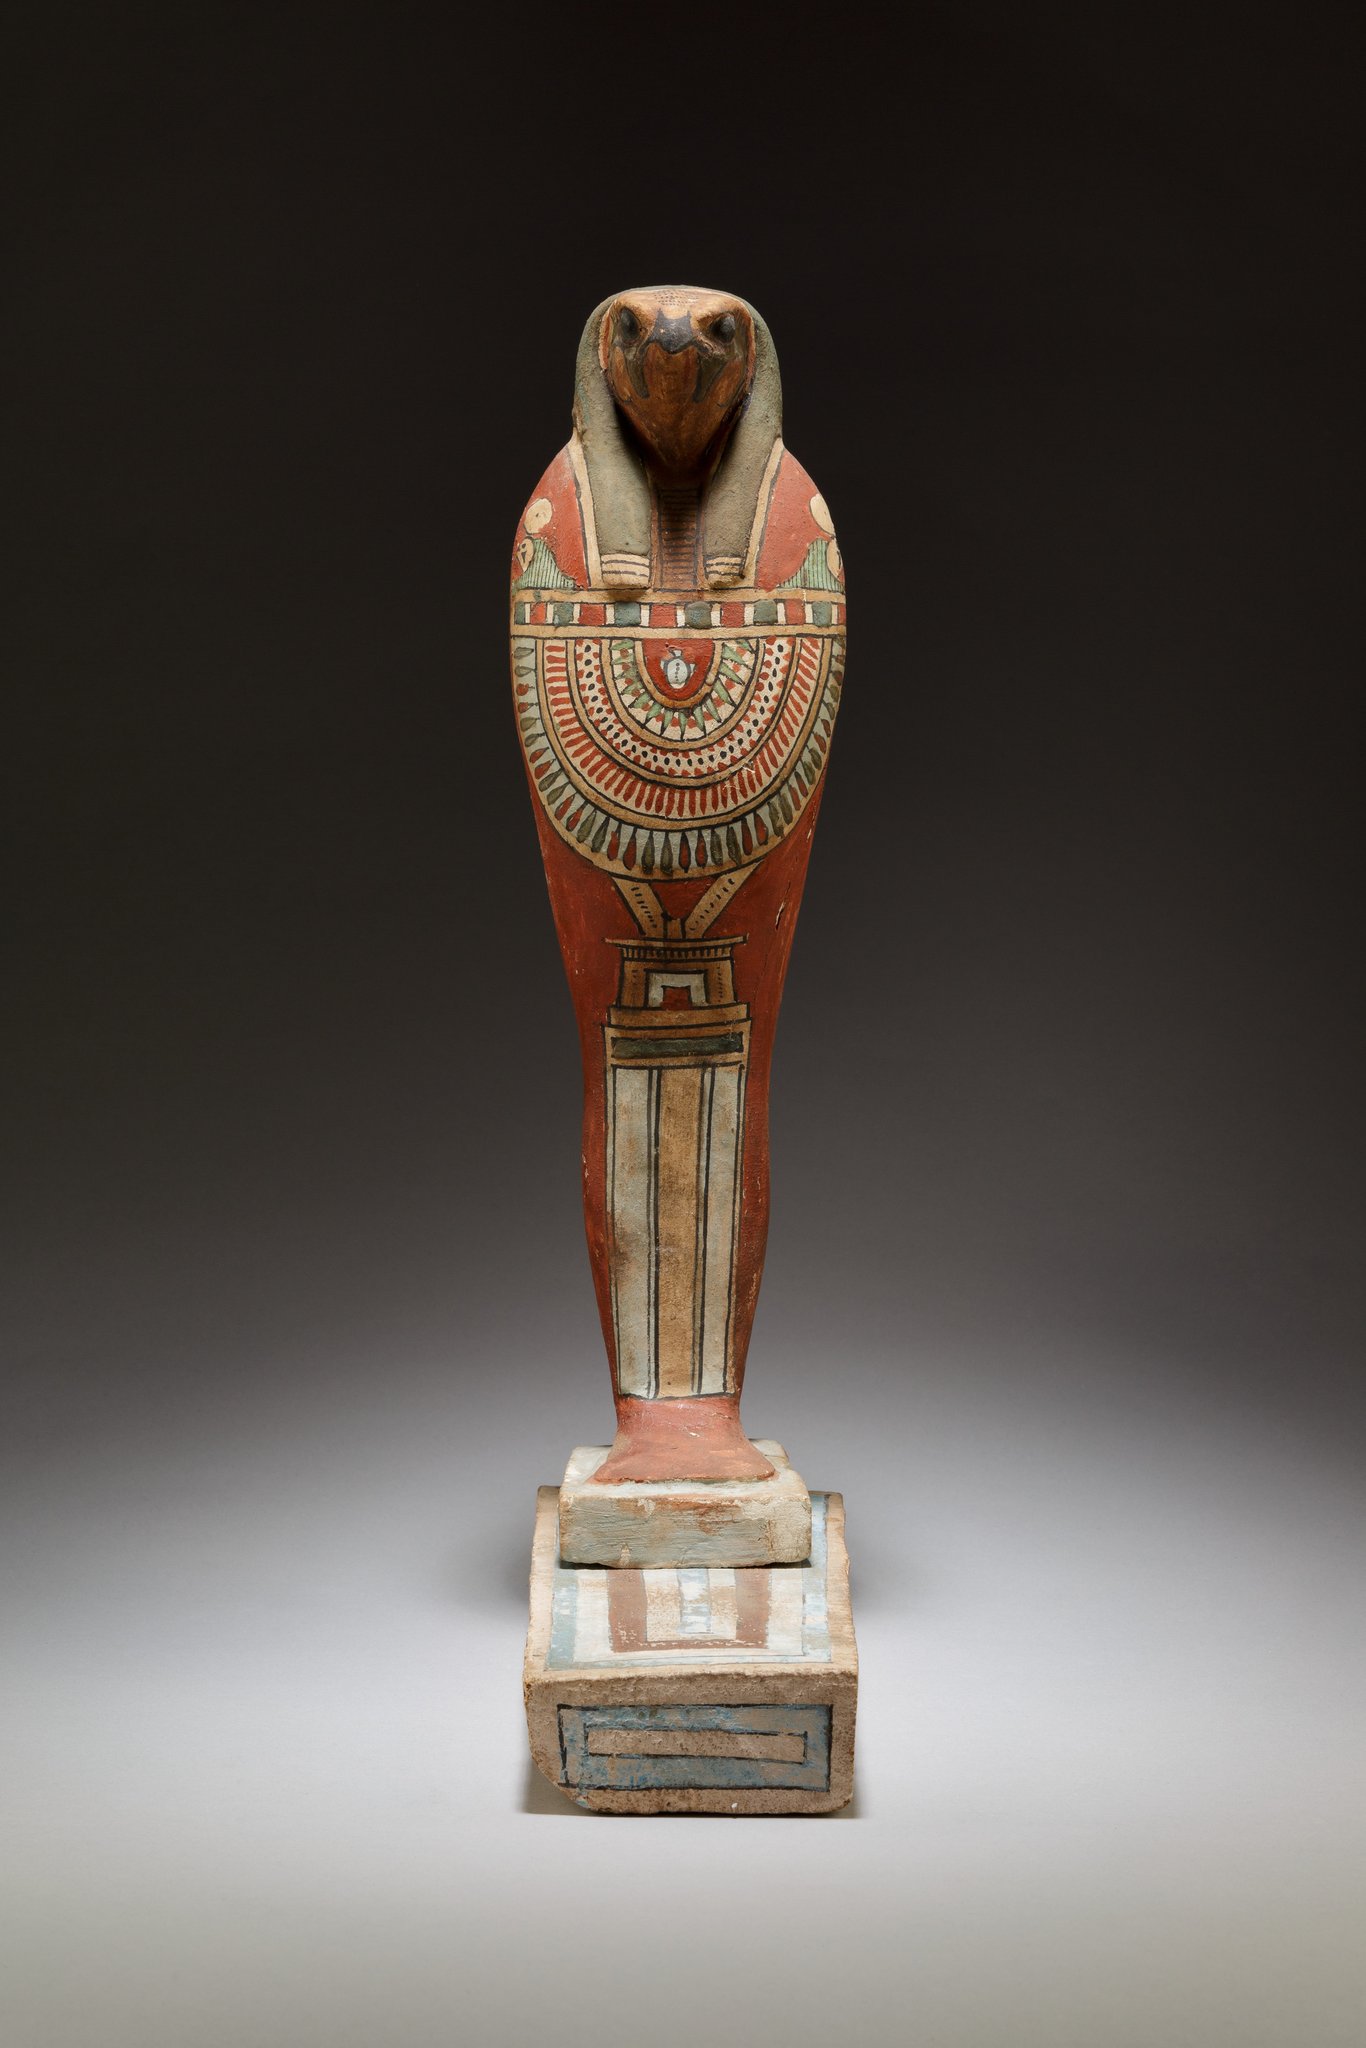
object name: funerary figure, qebehsenuef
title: Funerary Figure of Qebehsenuef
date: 400-30 BCE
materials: wood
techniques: painting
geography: middle egypt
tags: falcons